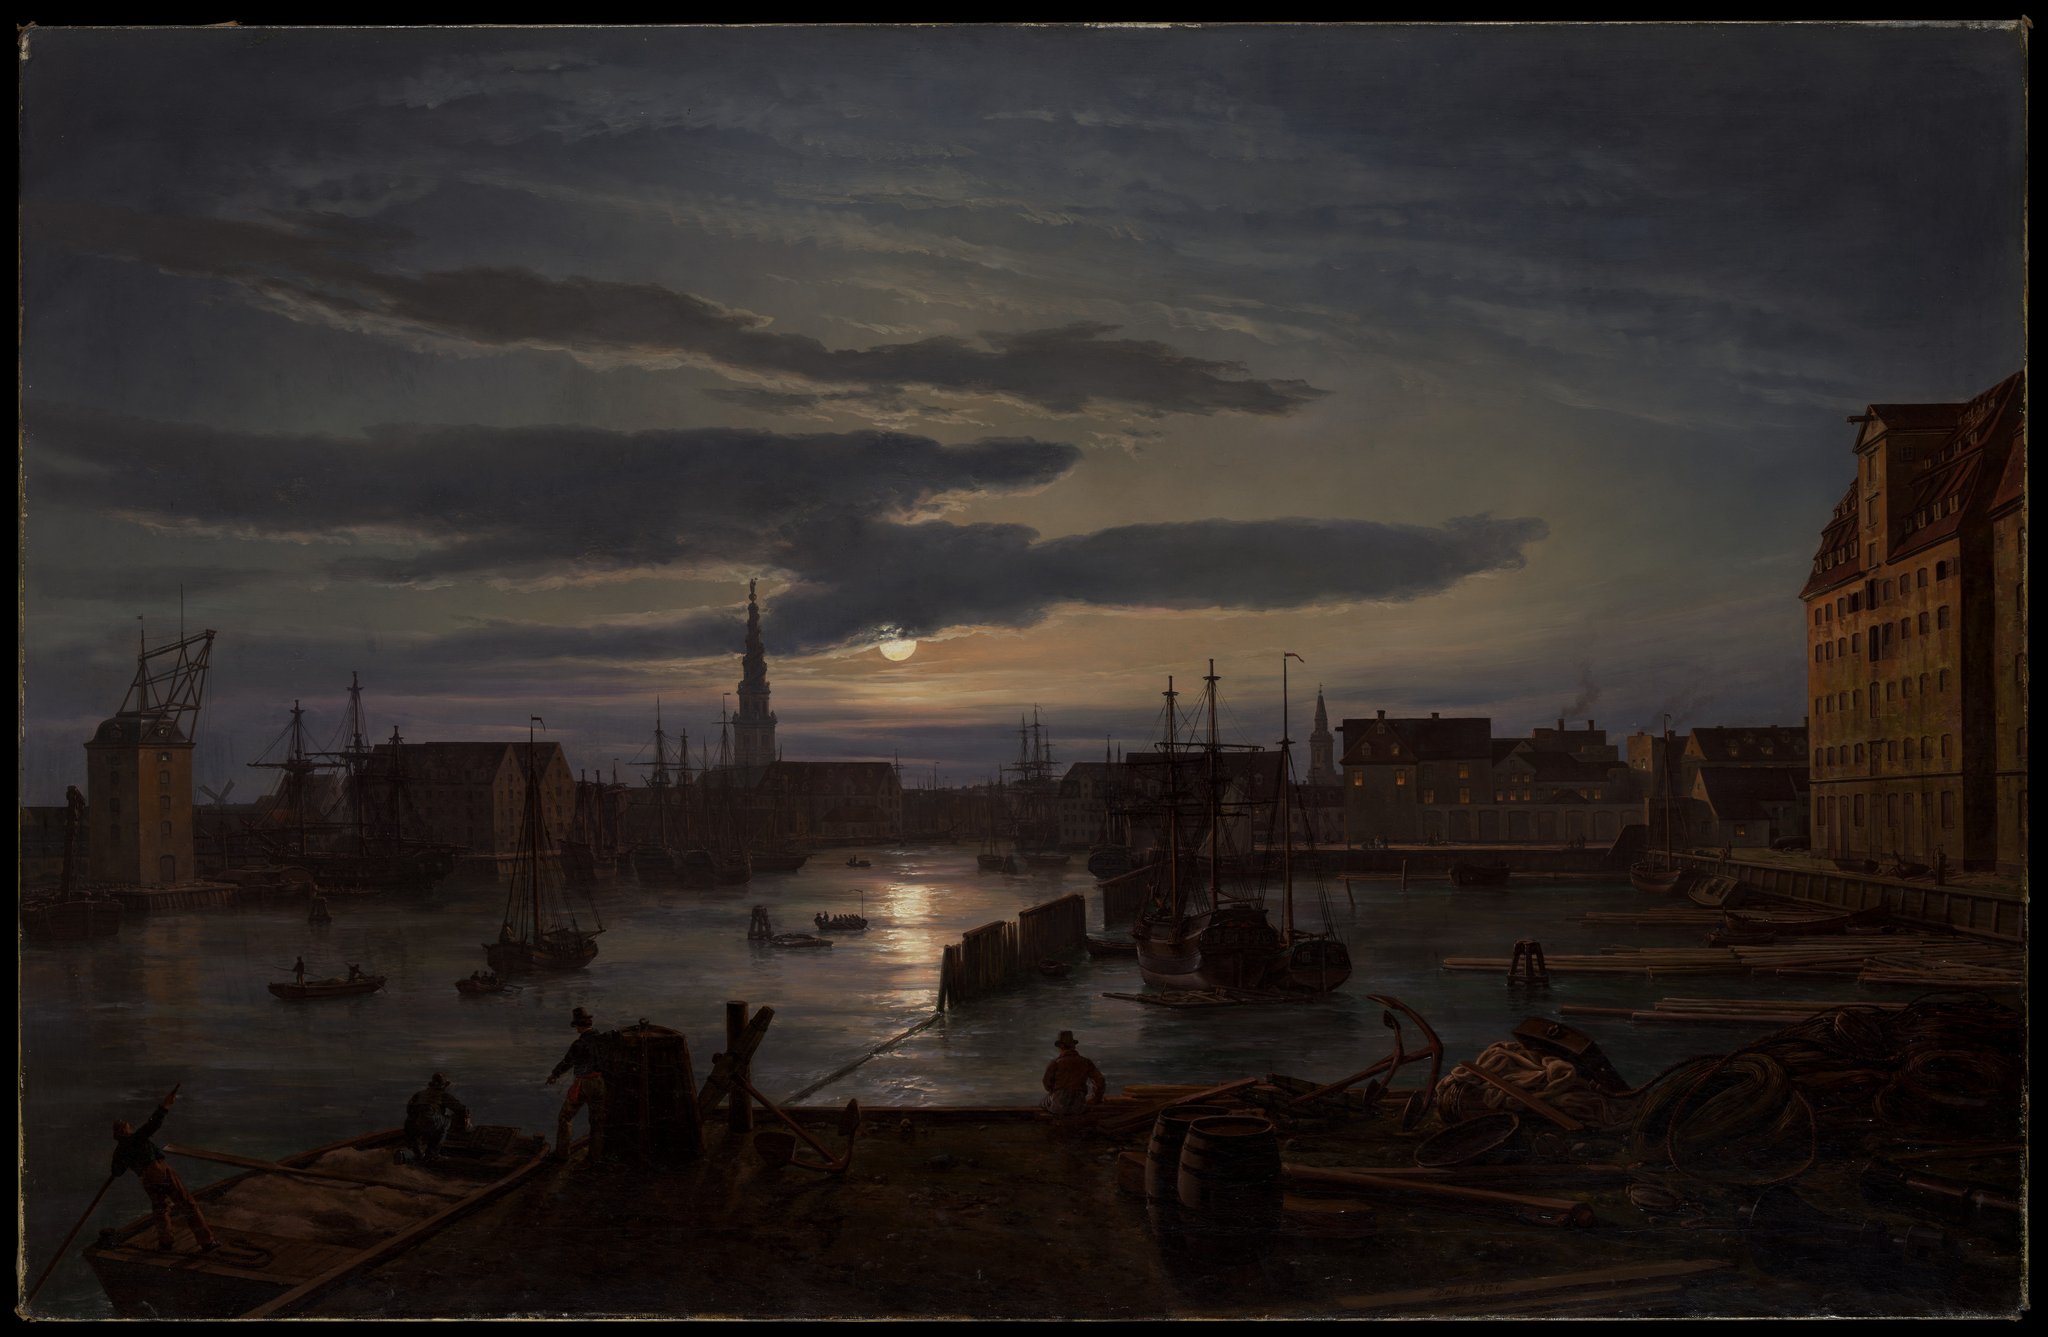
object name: painting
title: Copenhagen Harbor by Moonlight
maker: johan christian dahl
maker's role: artist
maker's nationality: norwegian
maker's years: 1788-1857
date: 1846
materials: canvas, oil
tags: moon,night,boats,harbors